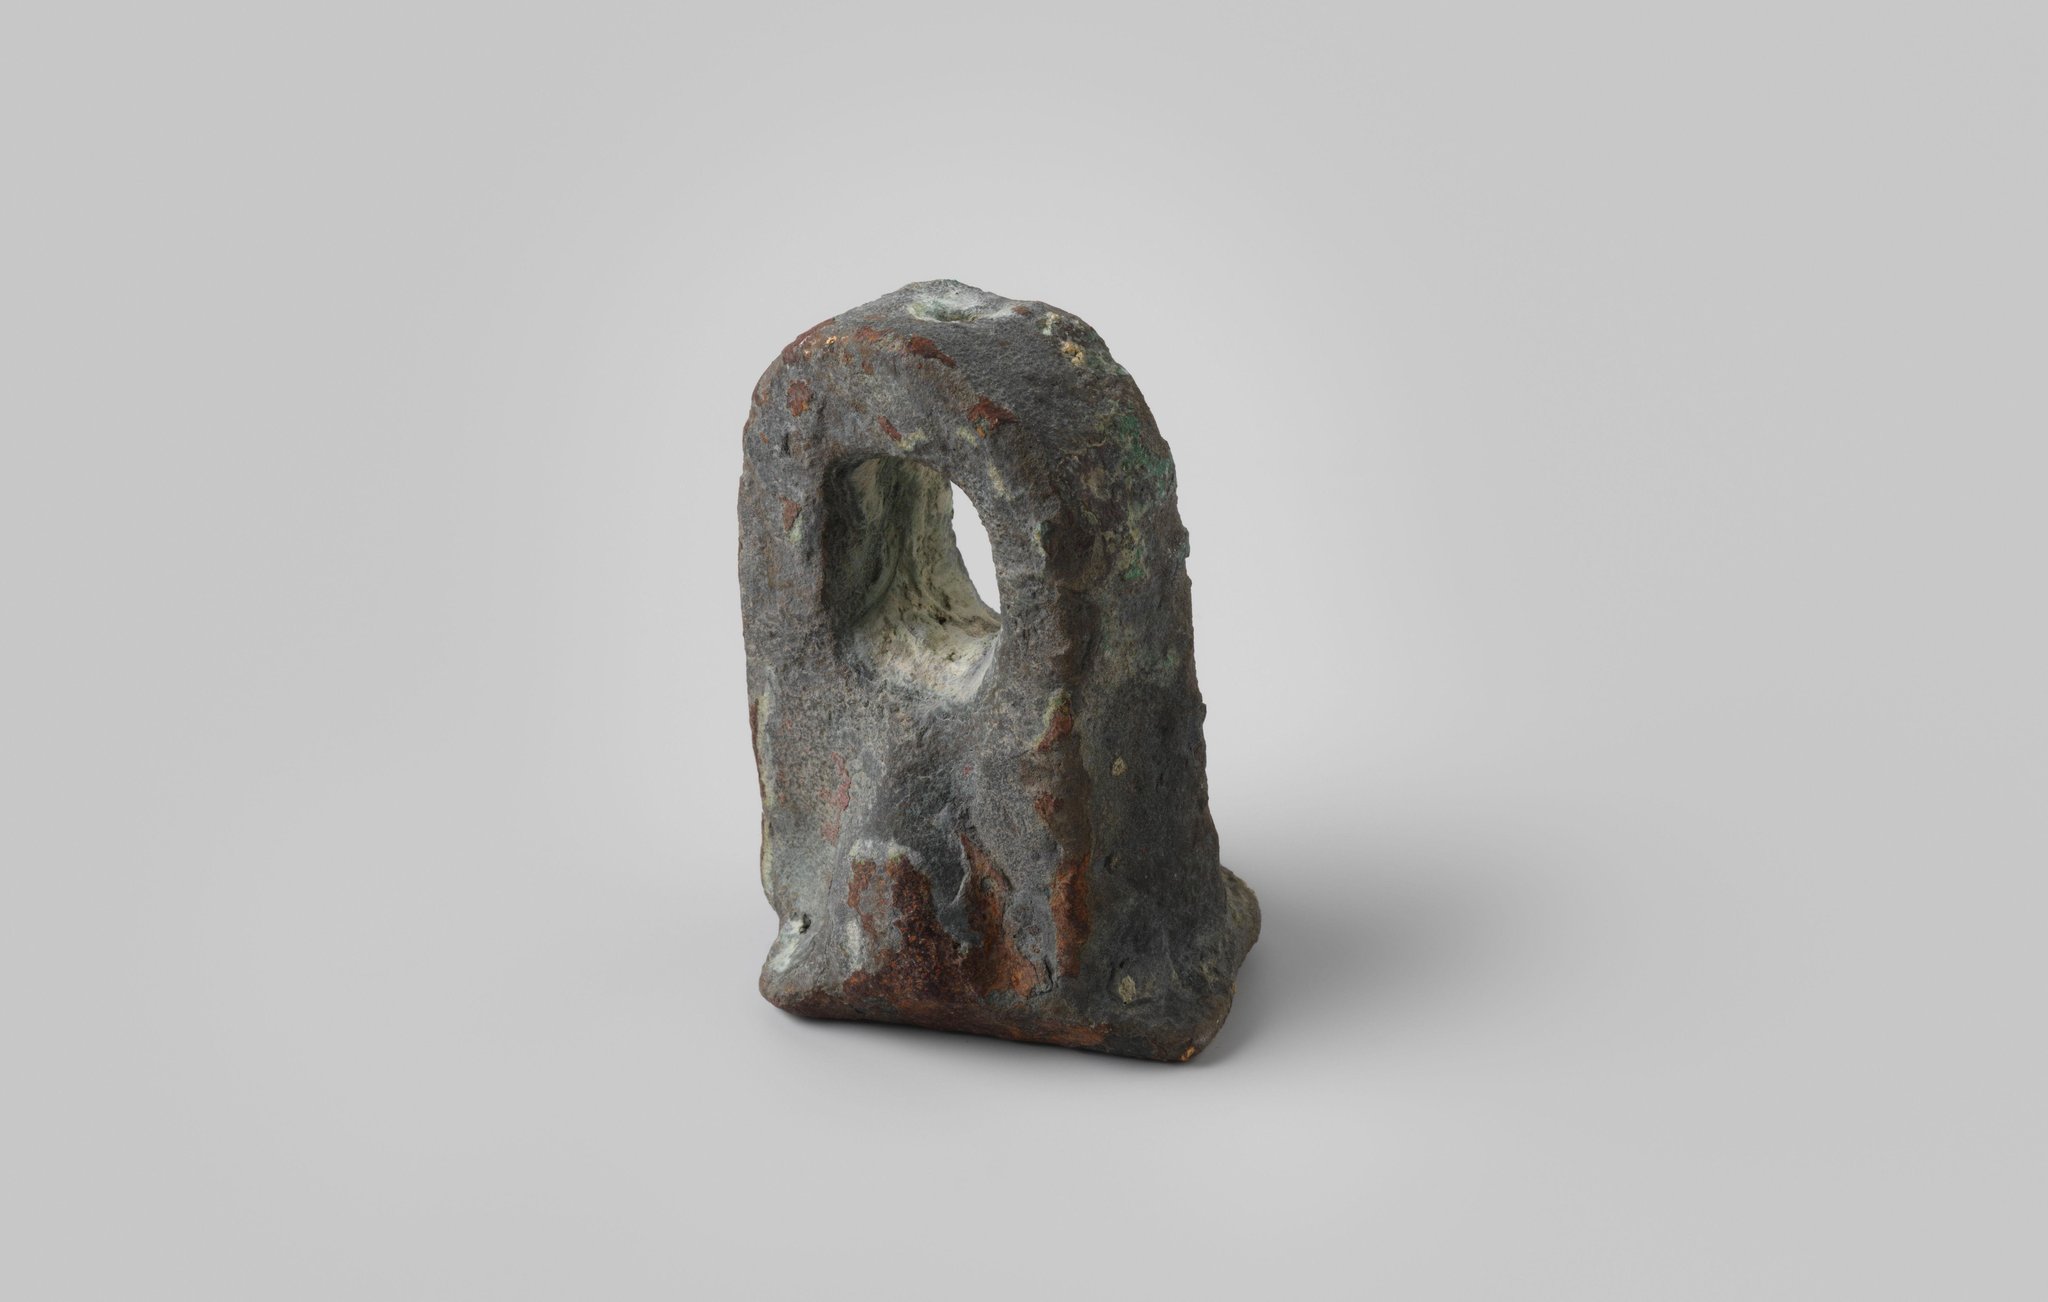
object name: ship bell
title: Suspension loop of a ship's bell from the wreck of the Dutch East Indiaman Hollandia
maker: Anonymous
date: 1700-1743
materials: copper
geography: netherlands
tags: verenigde oostindische compagnie, hollandia (schip), annet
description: Acoustic, bell (ship's); fragment, suspension loop: flat, semicircular ring, moulded base, flat with 2 holes underneath.